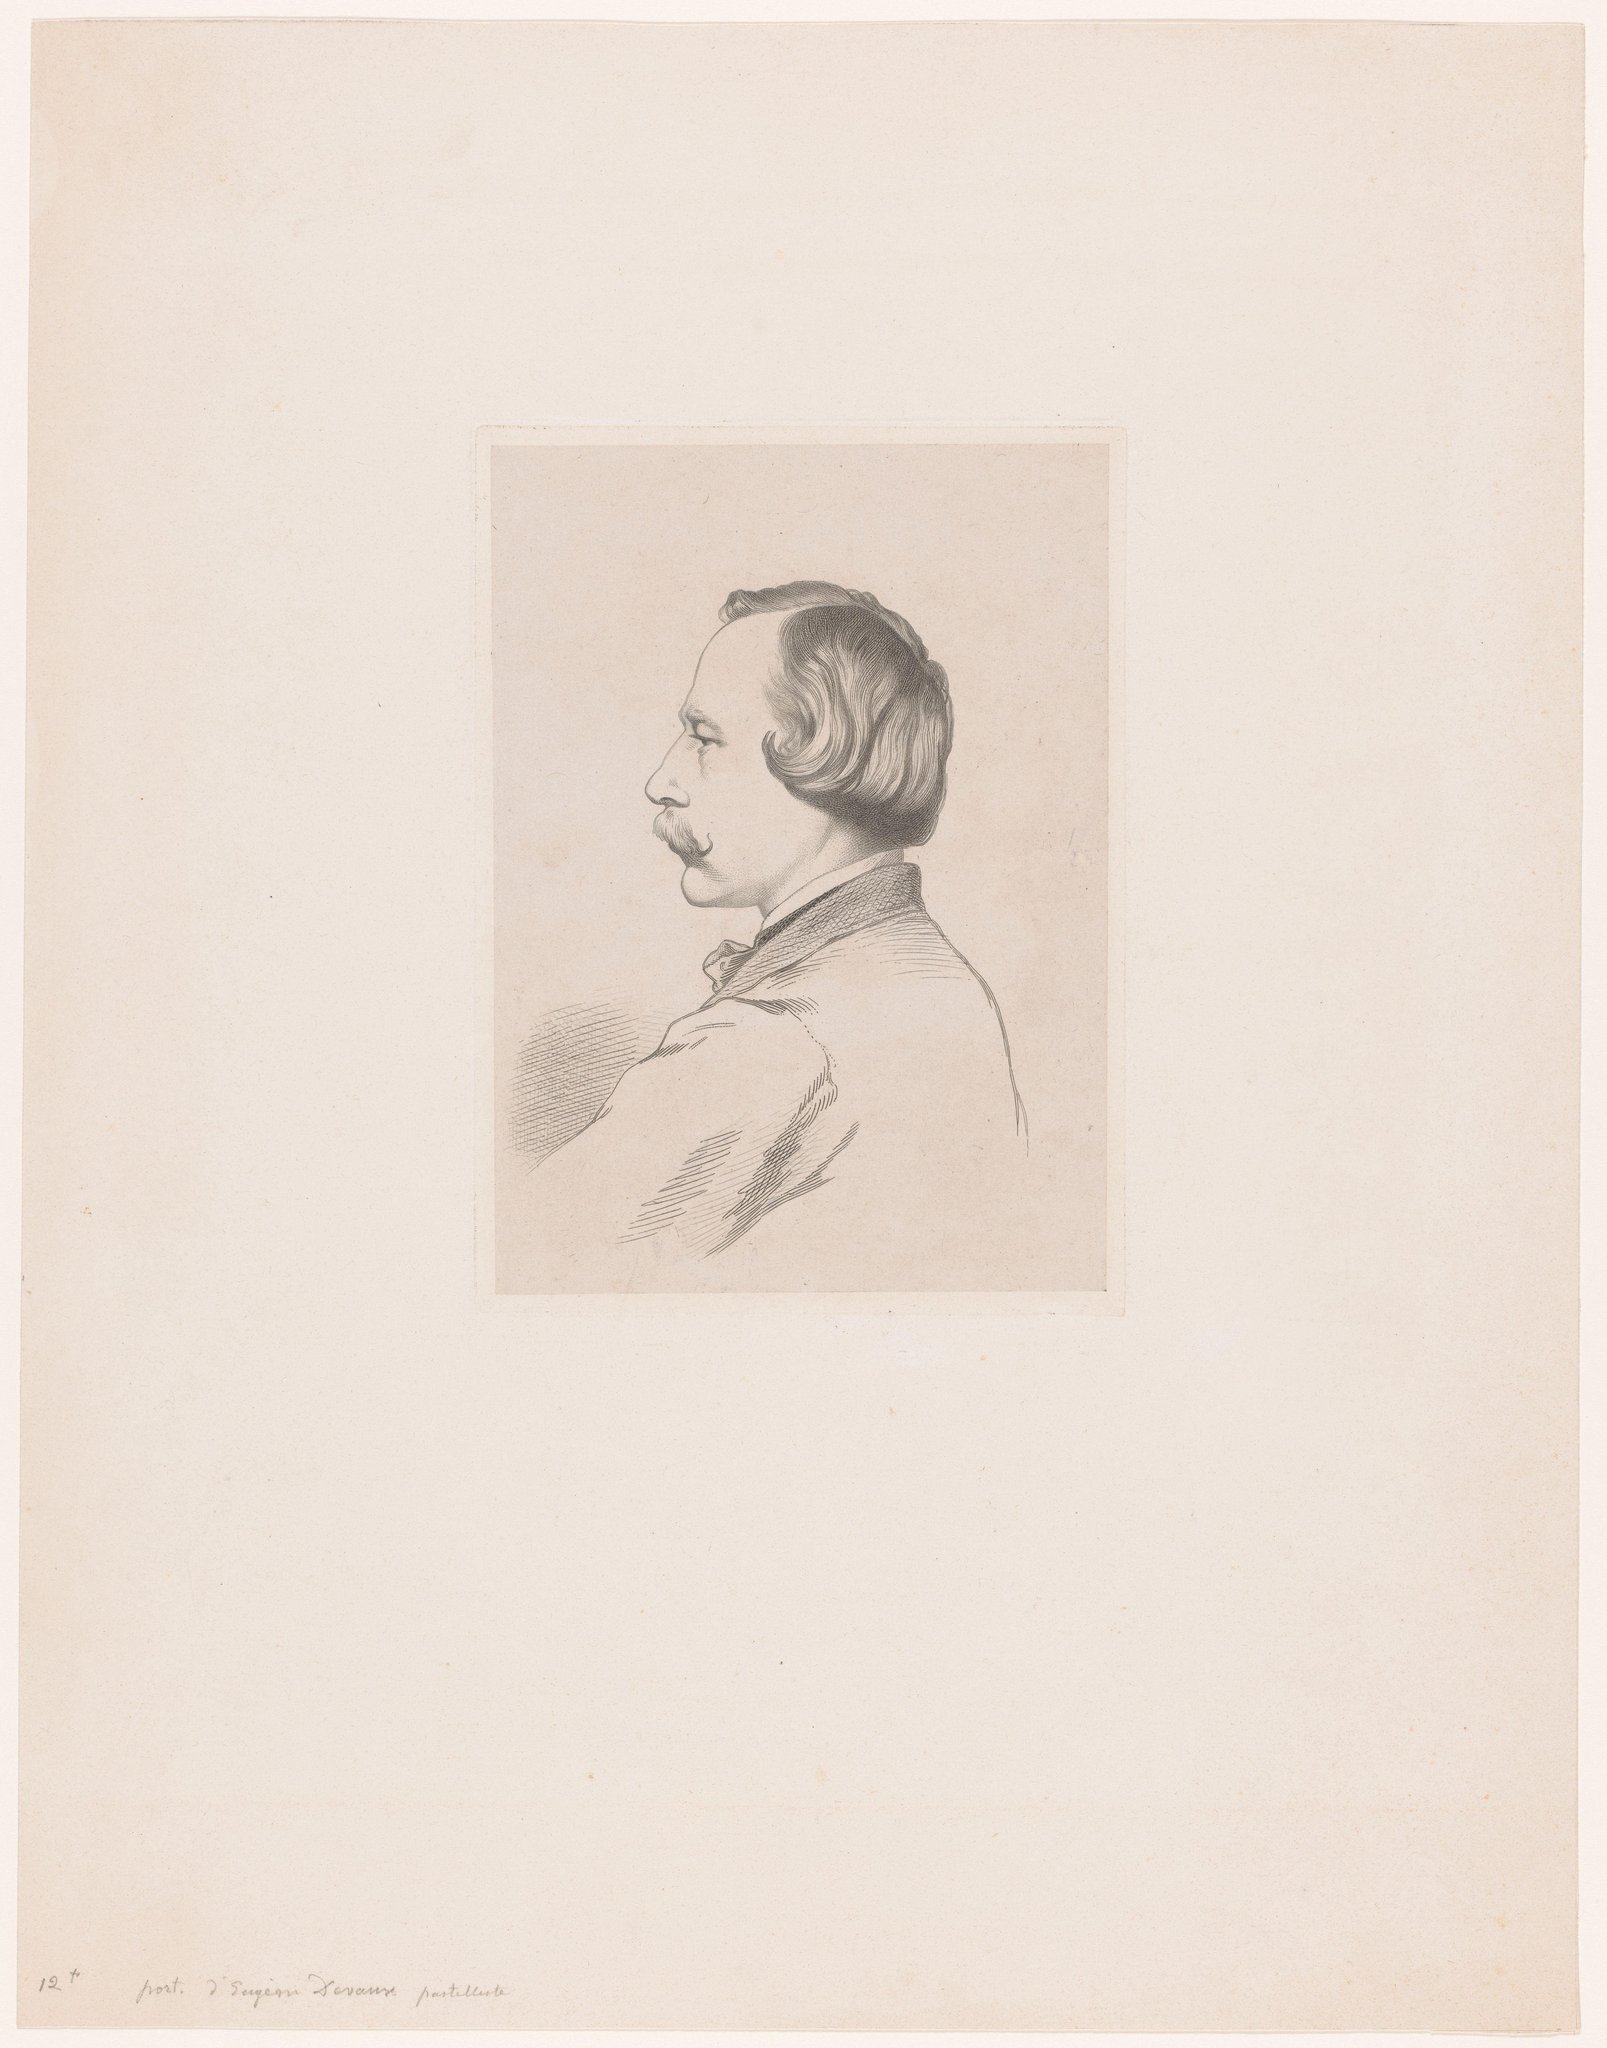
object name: print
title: Portret van Eugène Devaux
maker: jean-baptiste meunier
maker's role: print maker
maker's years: 1821-1900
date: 1831-1888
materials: paper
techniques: etching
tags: adult man, historical persons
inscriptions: collector's mark: Lugt 2228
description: Volgens de inventaris gaat het om 'Eug. Devaux'.